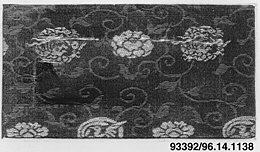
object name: piece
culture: japanese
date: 1701-1900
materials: silk